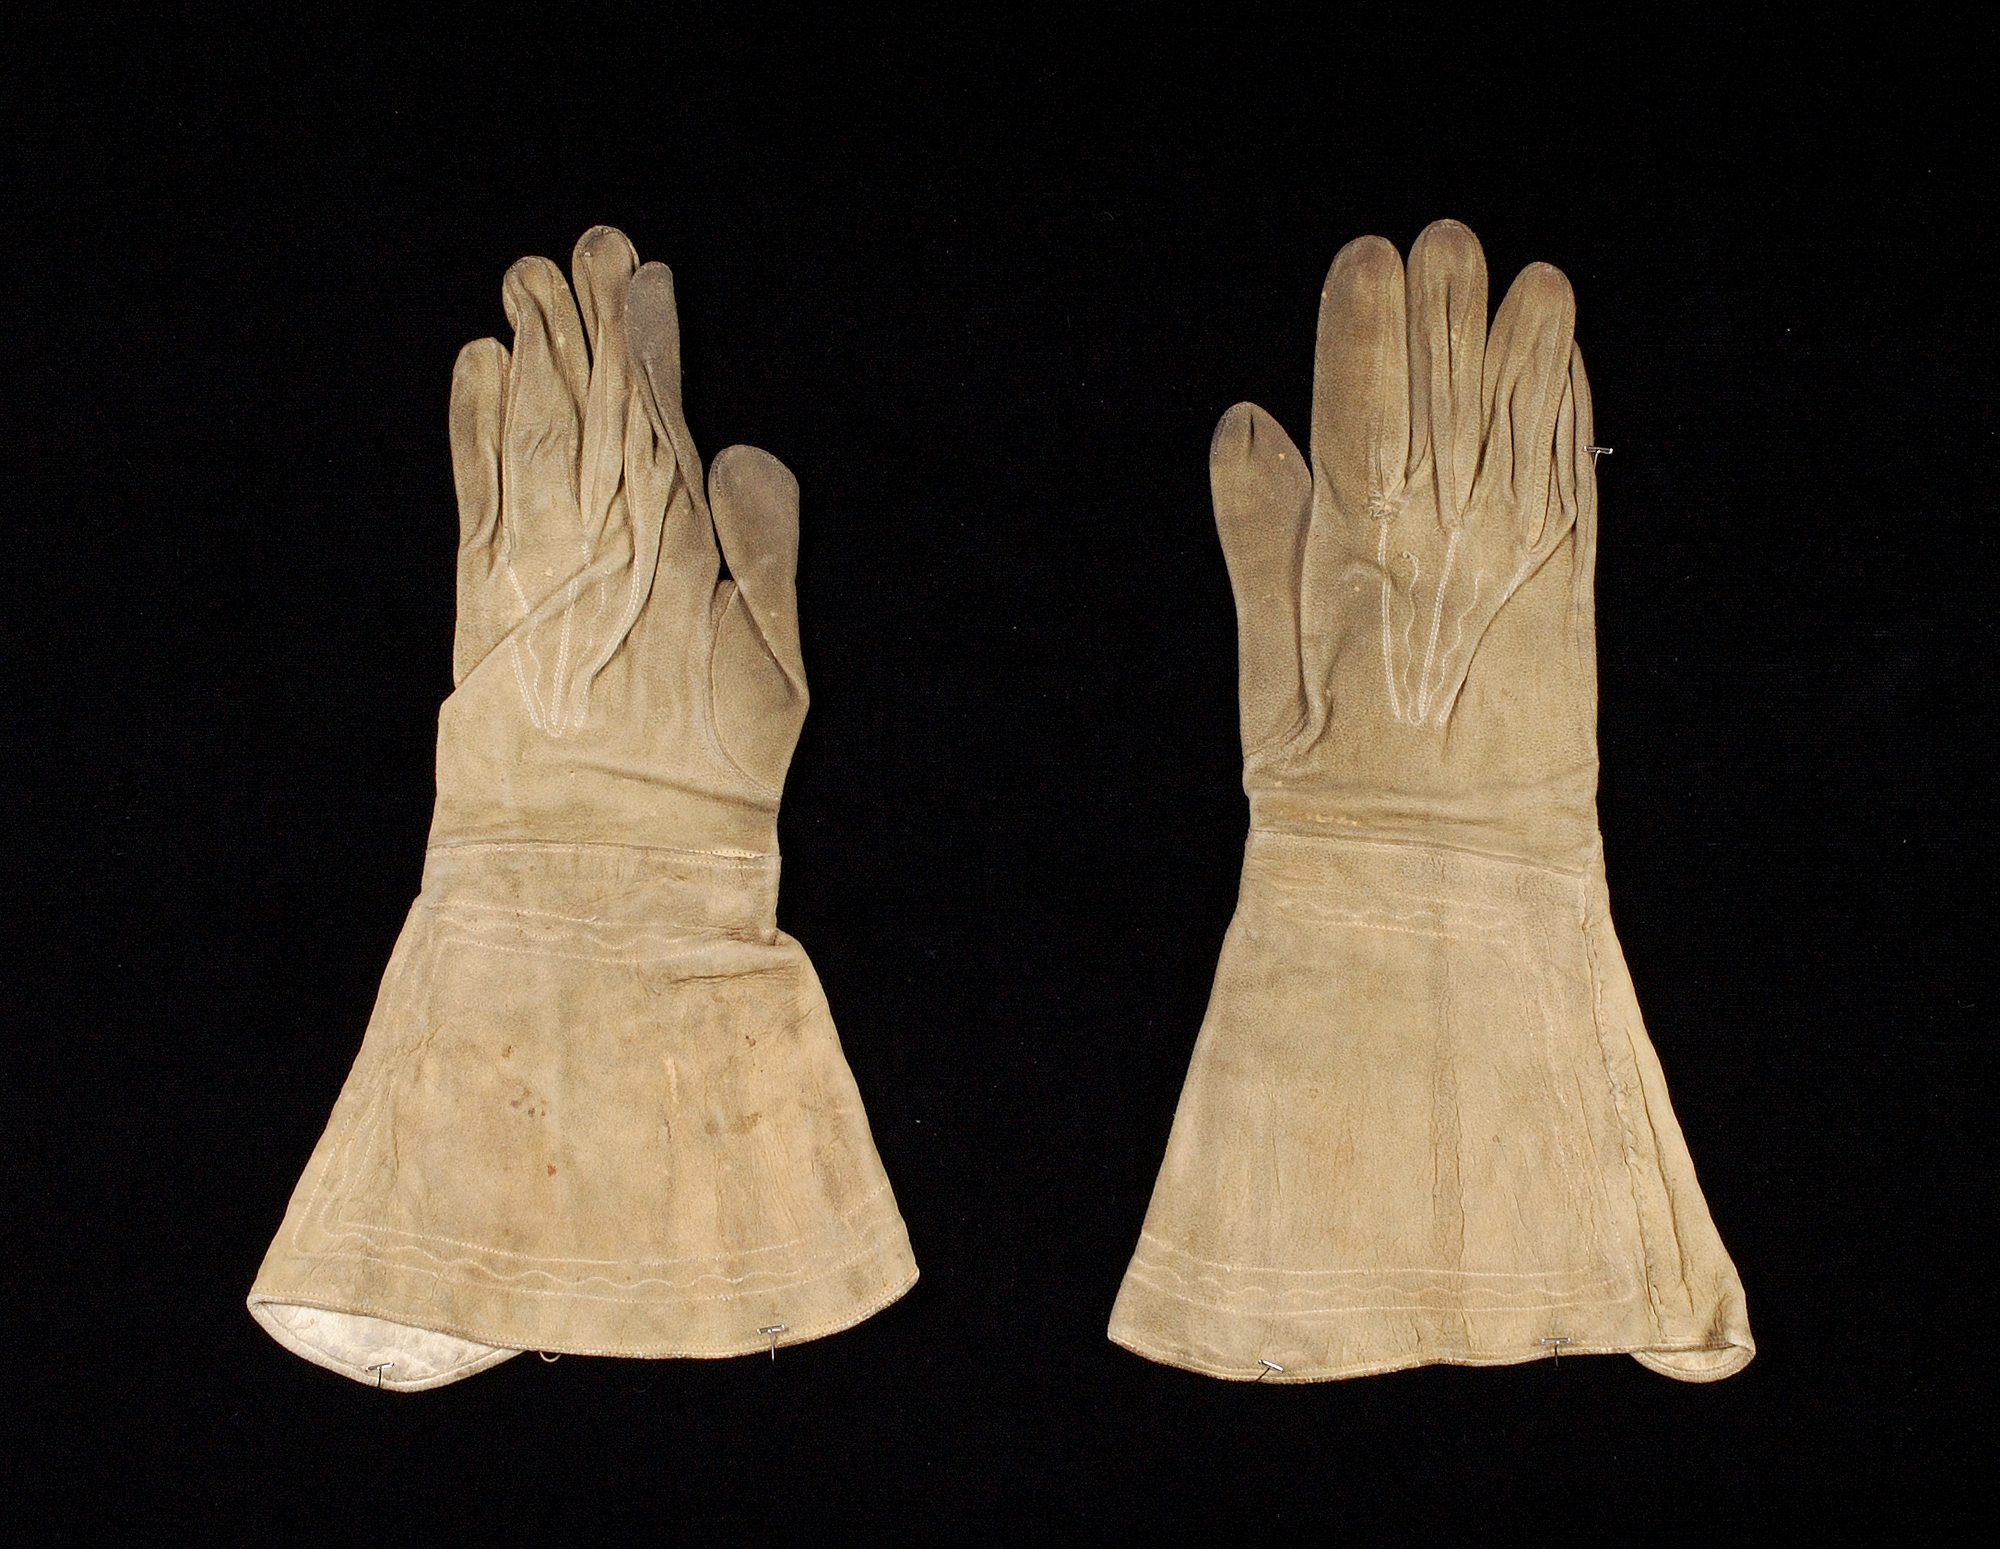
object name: glove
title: Gloves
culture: american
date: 1862-1864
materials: leather